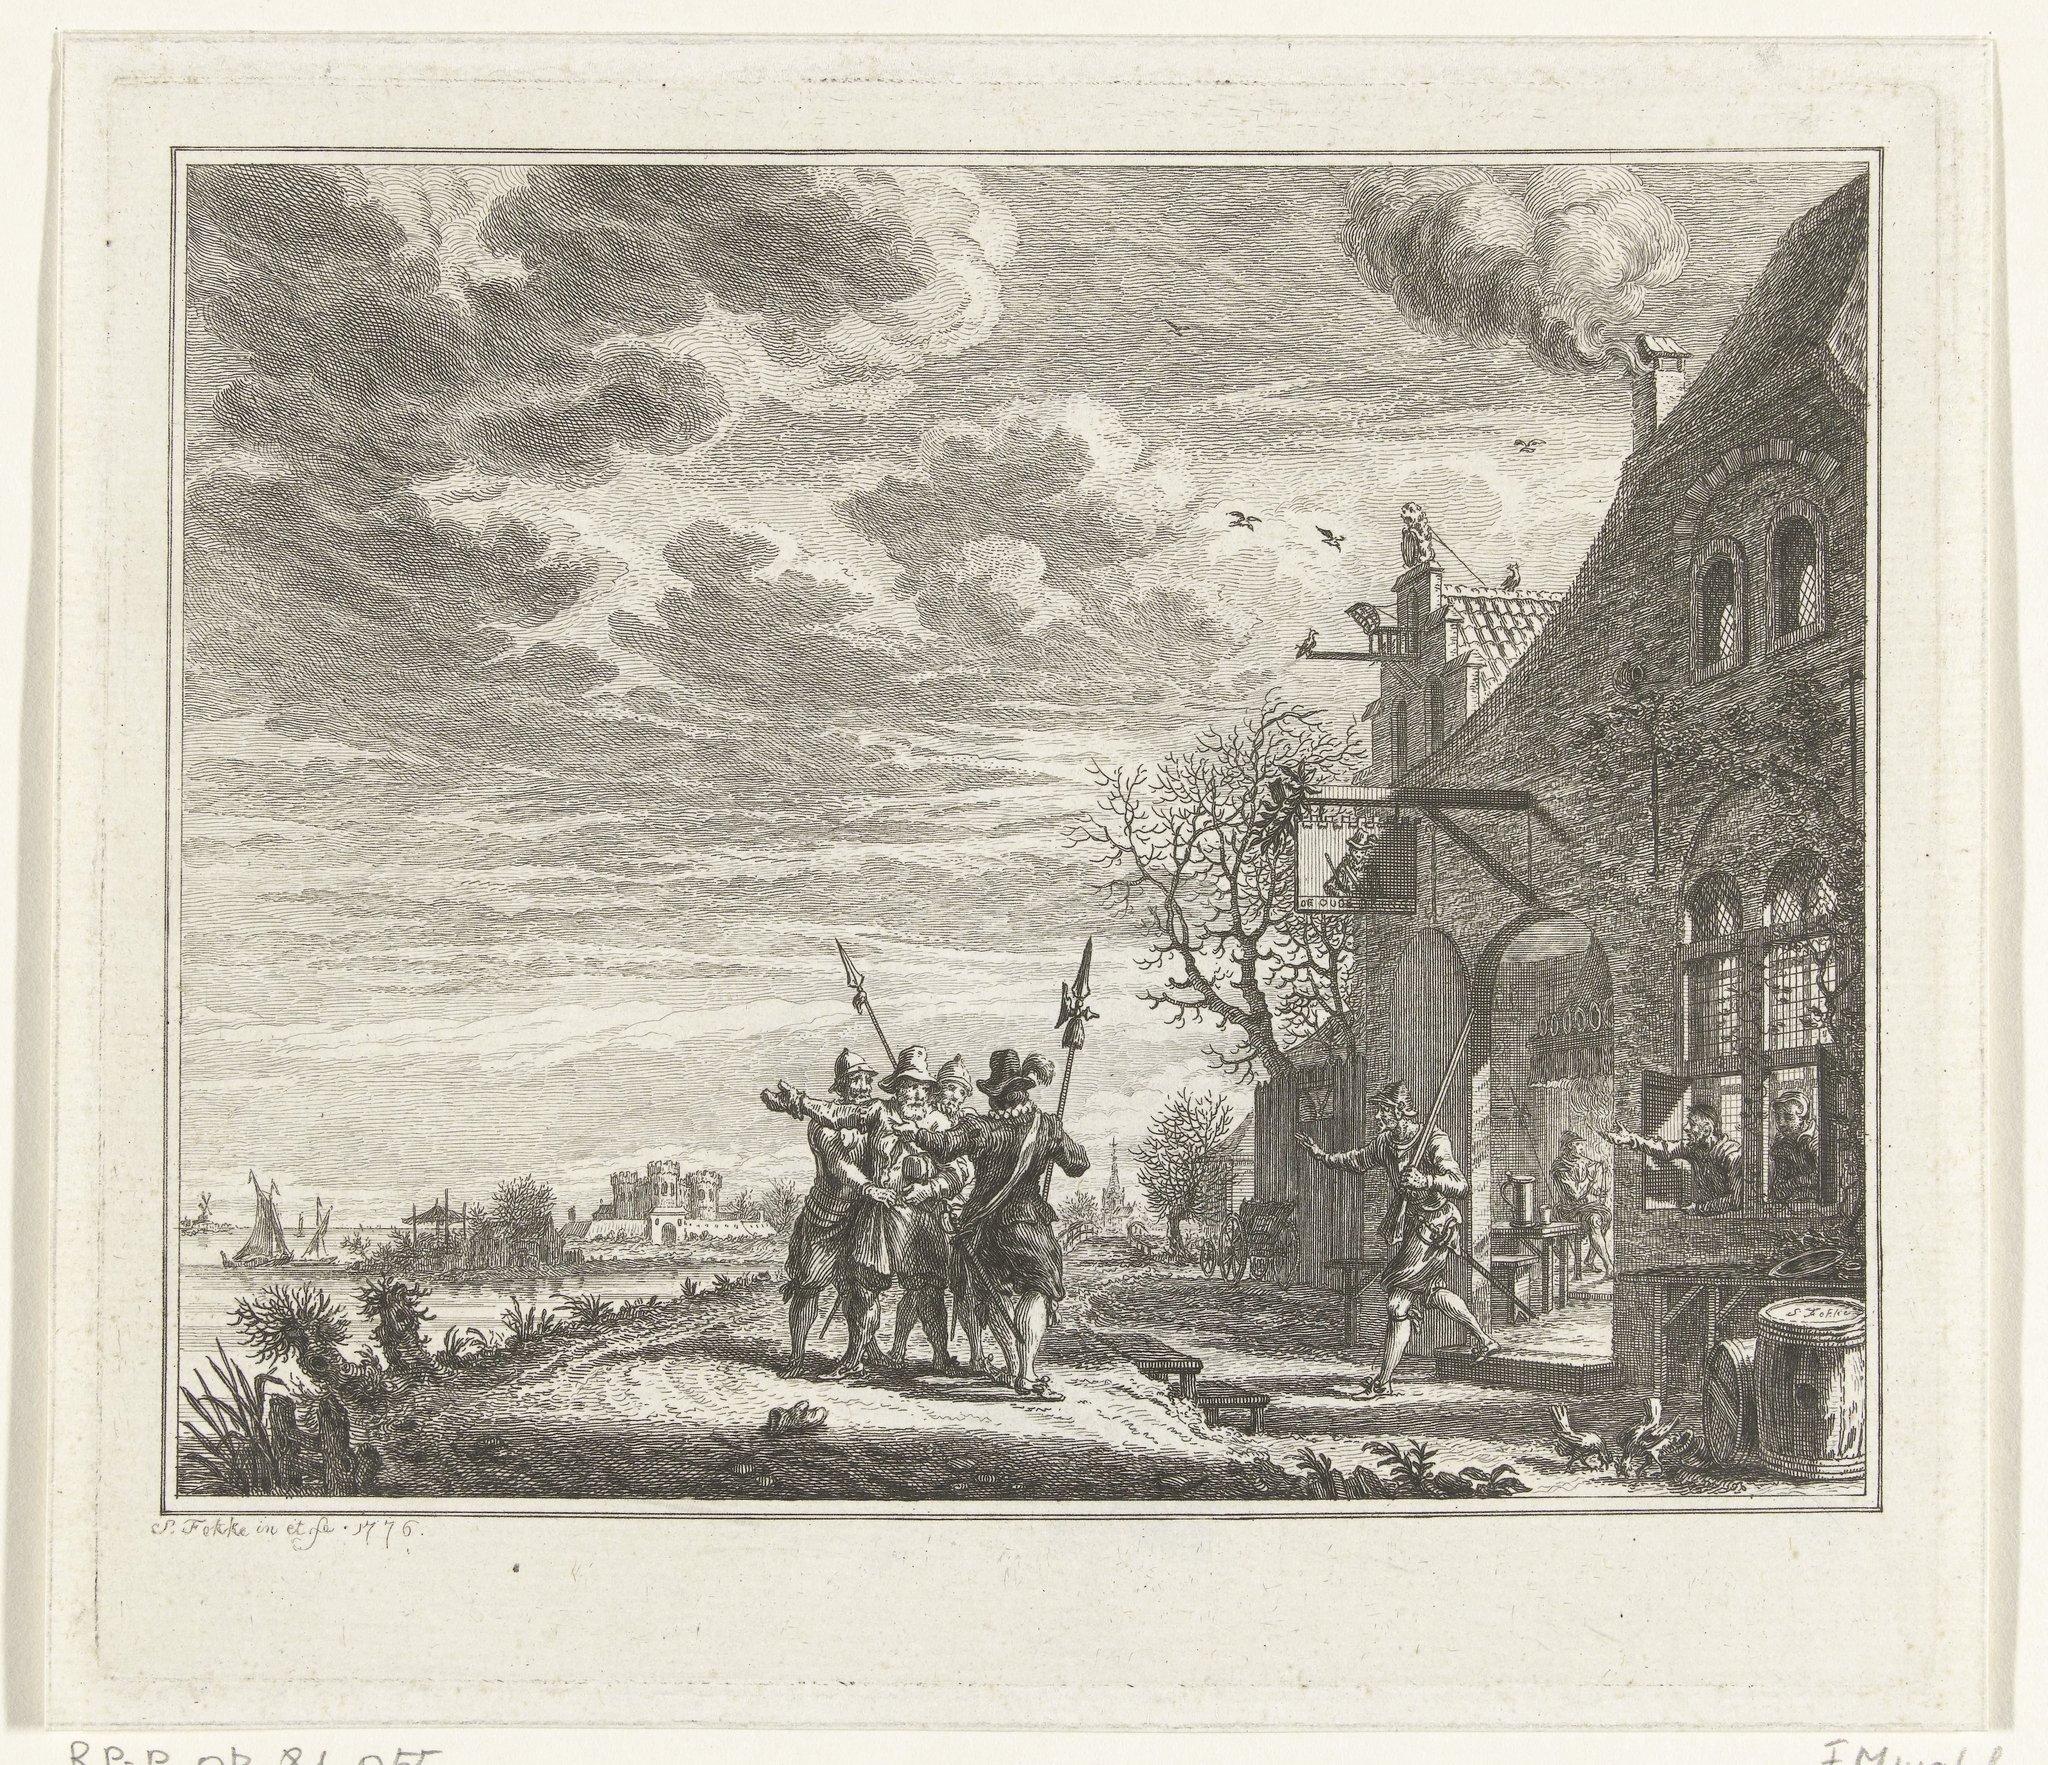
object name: print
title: De gevangenneming van Henricus Slatius, 1623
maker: simon fokke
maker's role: draughtsman, print maker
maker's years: 1712-1784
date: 1776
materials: paper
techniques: etching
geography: northern netherlands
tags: maurice (prince of orange), arrest (of criminal)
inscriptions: date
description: De gevangenneming van Henricus Slatius, één van de voortvluchtige samenzweerders tegen Maurits, voor een herberg bij Coevorden, maart 1623. Rechts de herberg met de bierkan staande op een tafel.